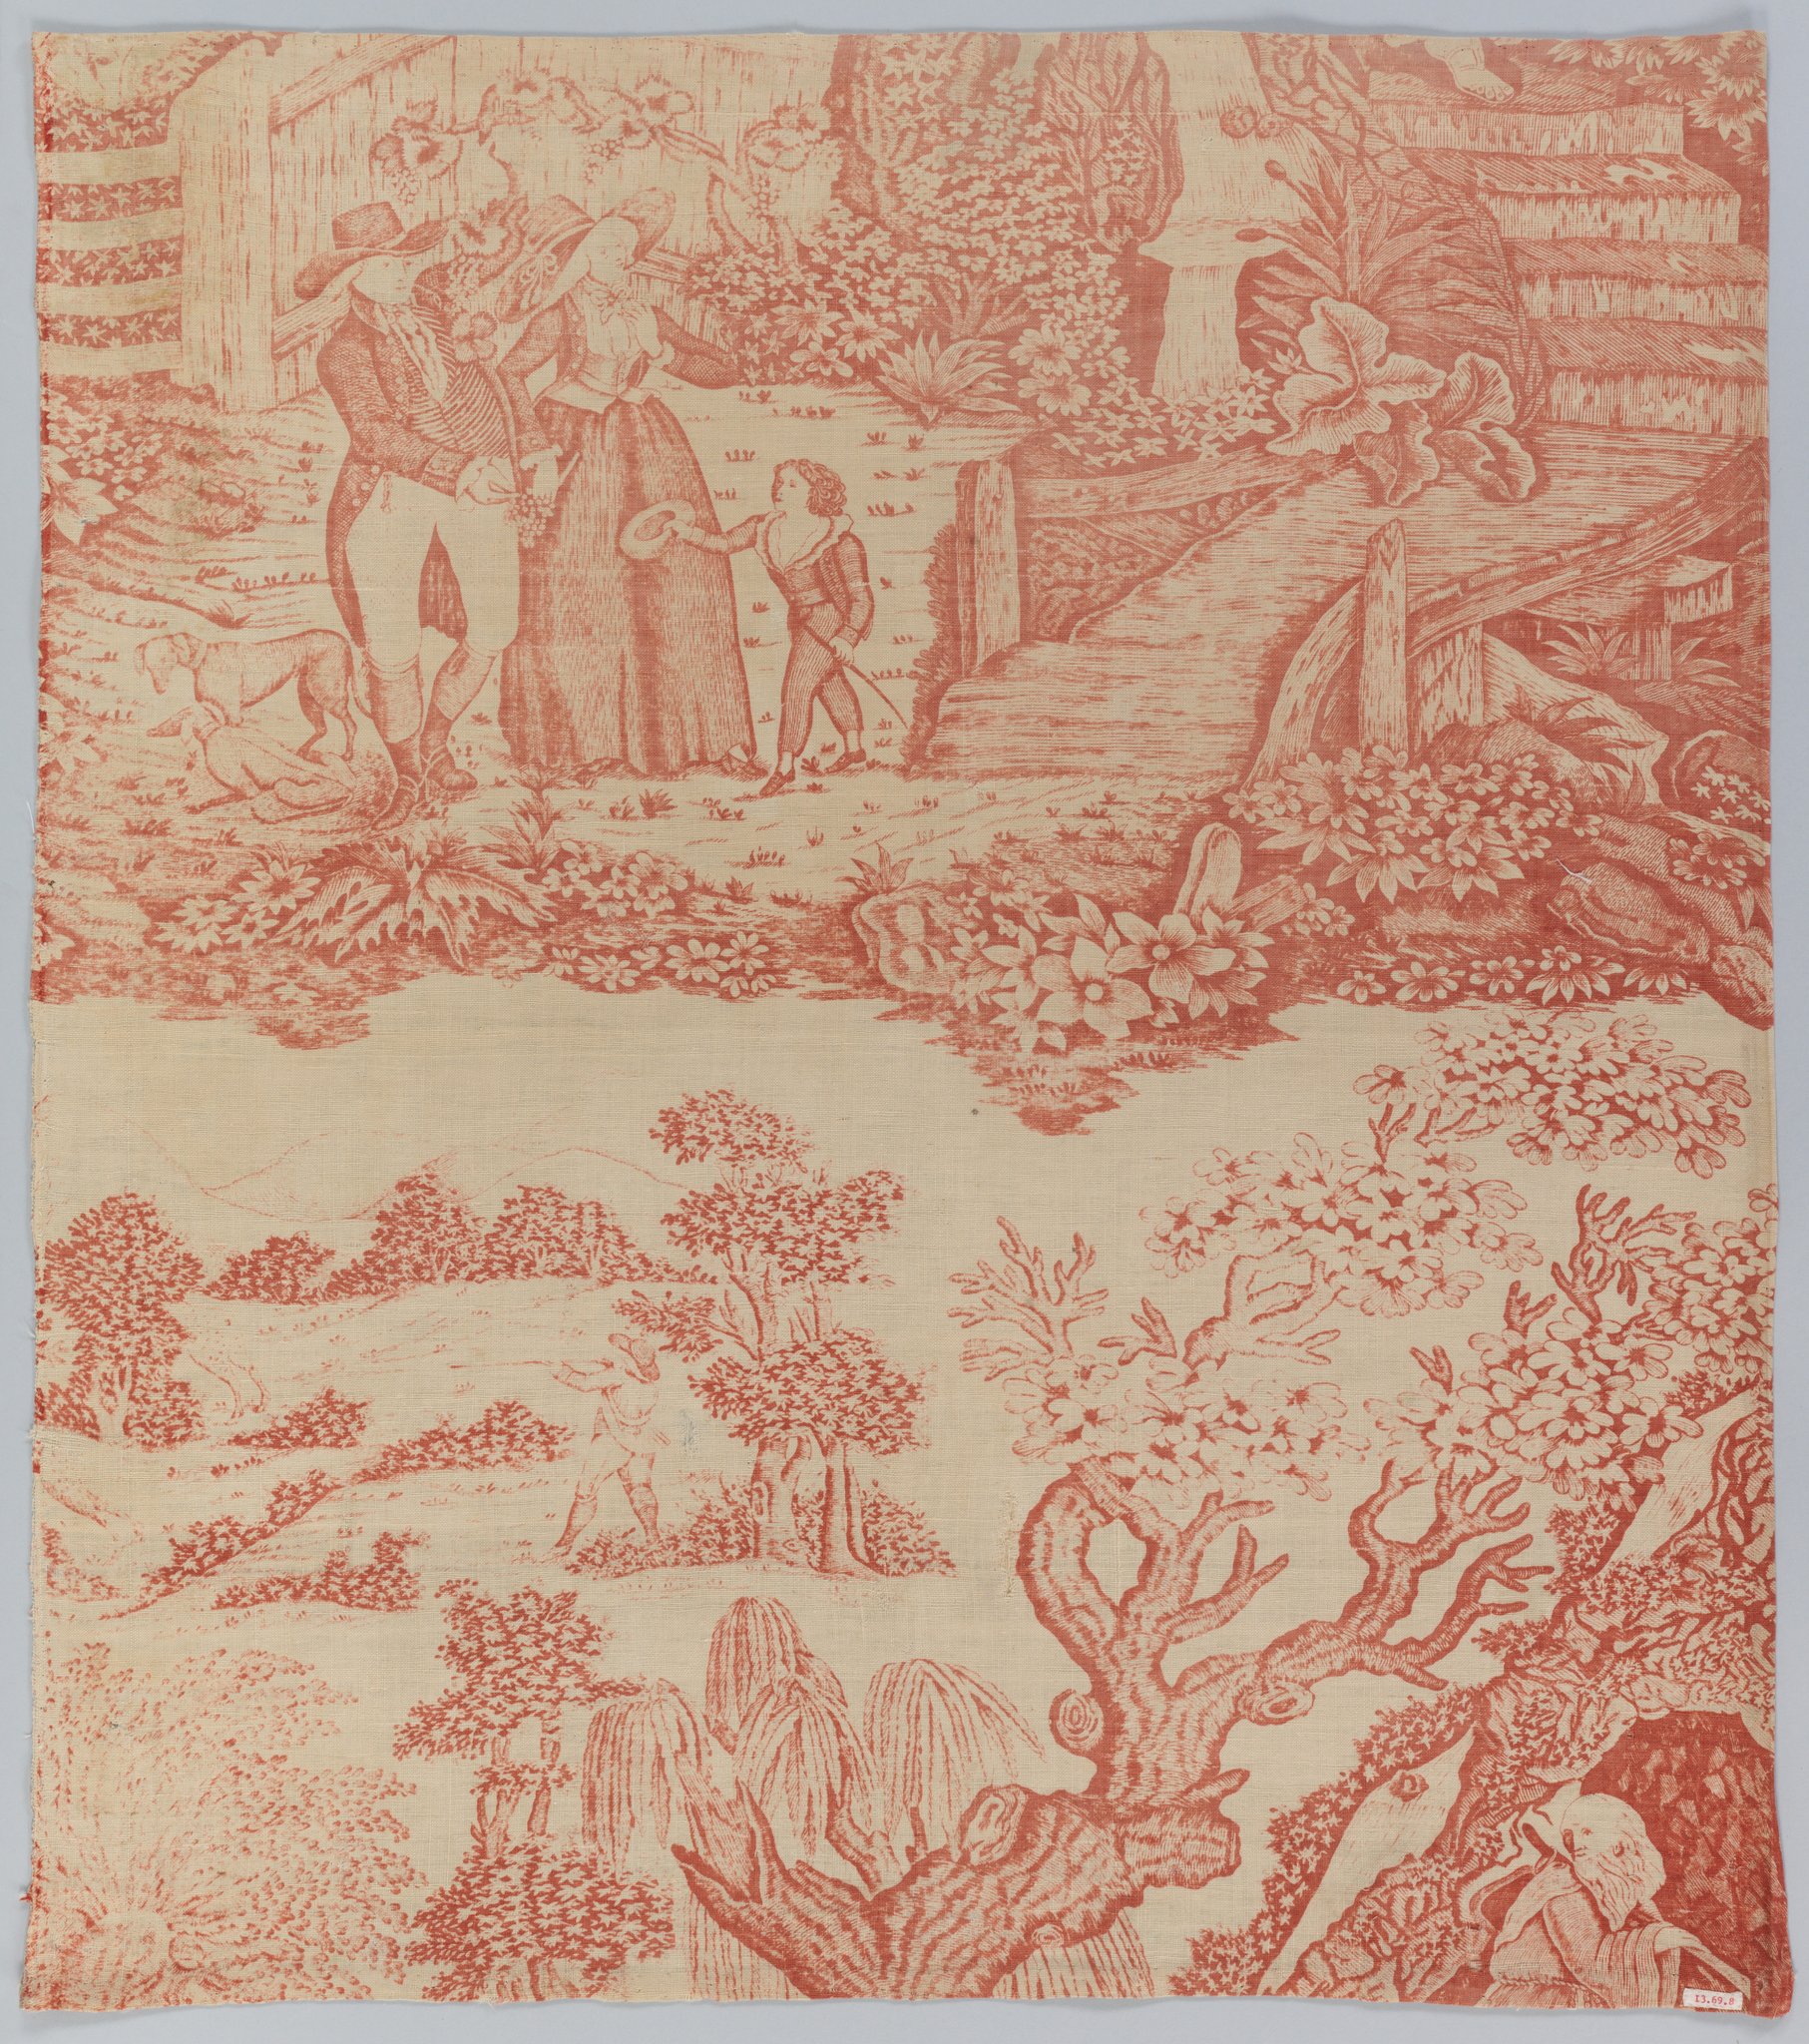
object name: piece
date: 1785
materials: cotton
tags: grapes,boys,men,women,dogs